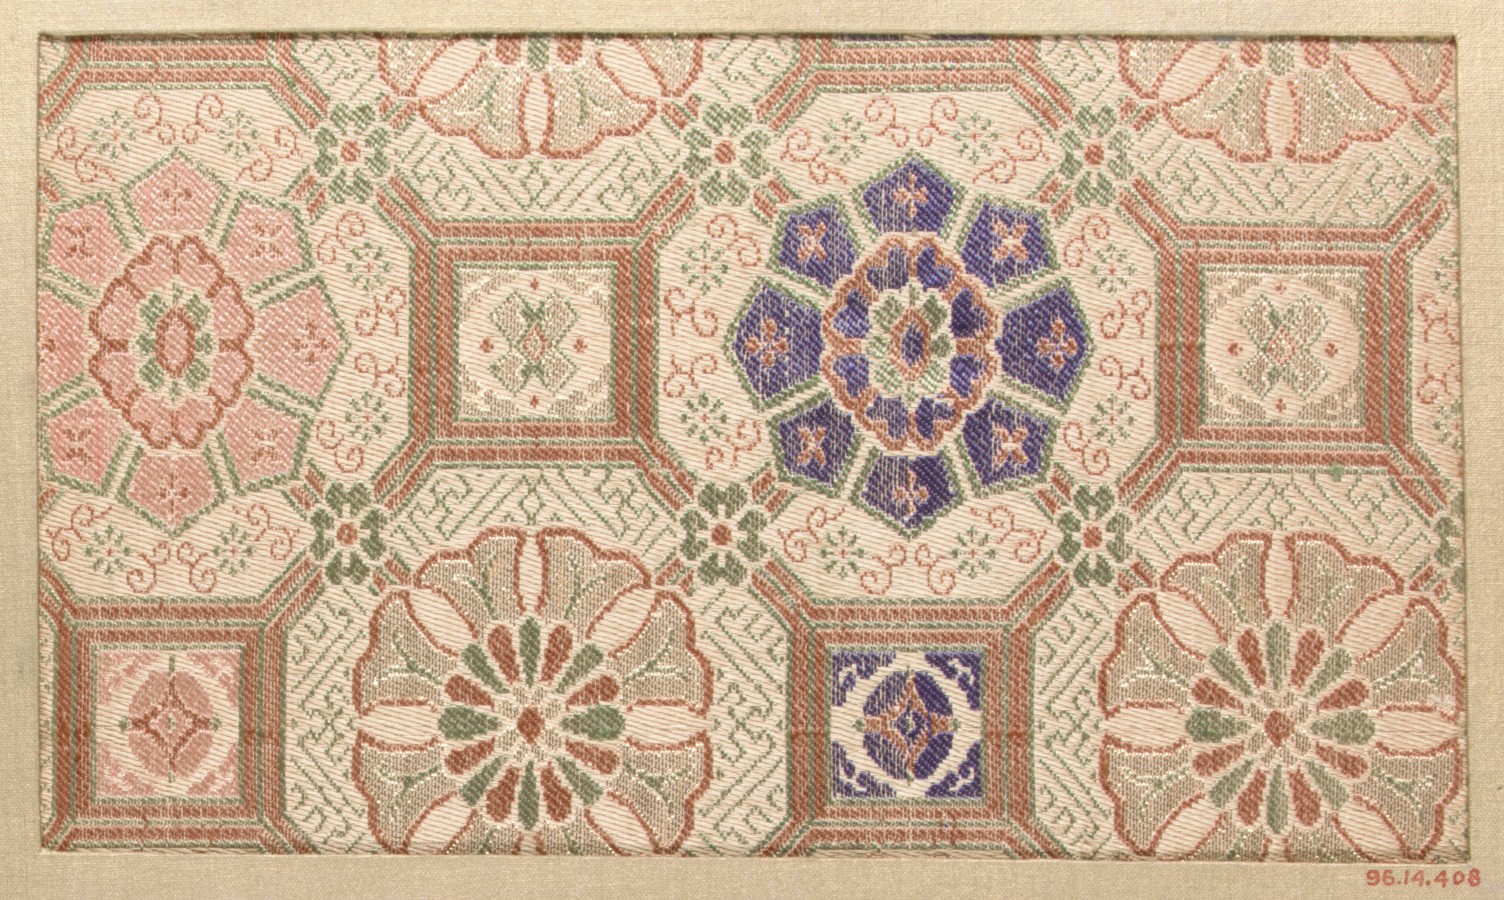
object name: piece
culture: japanese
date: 1701-1900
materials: silk